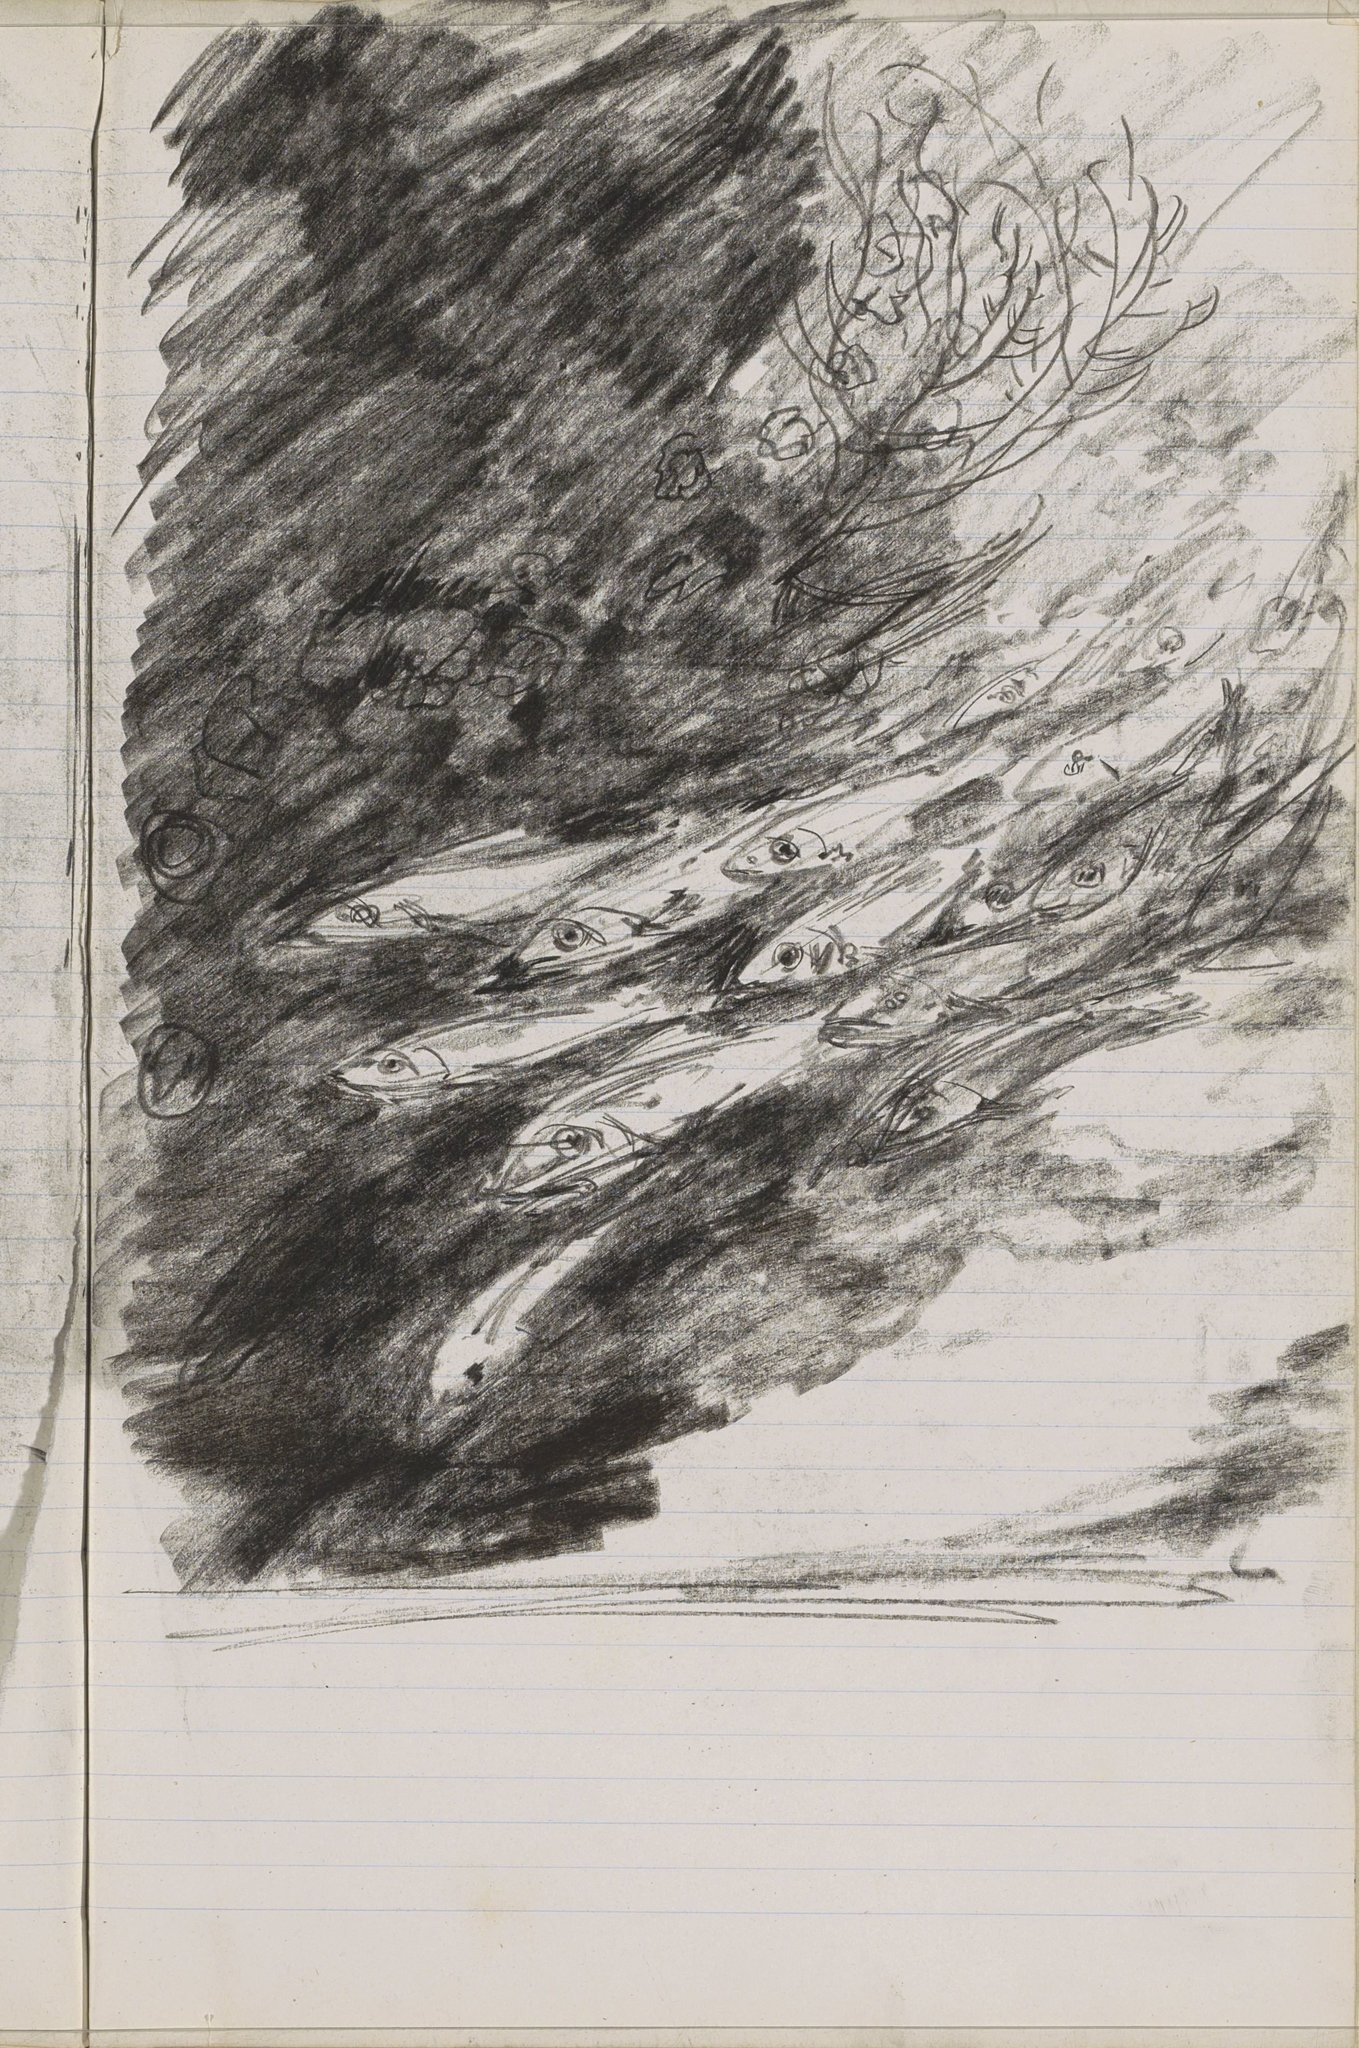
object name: sketchbook leaf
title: School vissen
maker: gerrit willem dijsselhof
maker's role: designer, draughtsman, print maker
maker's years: 1866-1924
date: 1901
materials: chalk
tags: fishes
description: Blad 74 recto uit een schetsboek met 79 bladen.